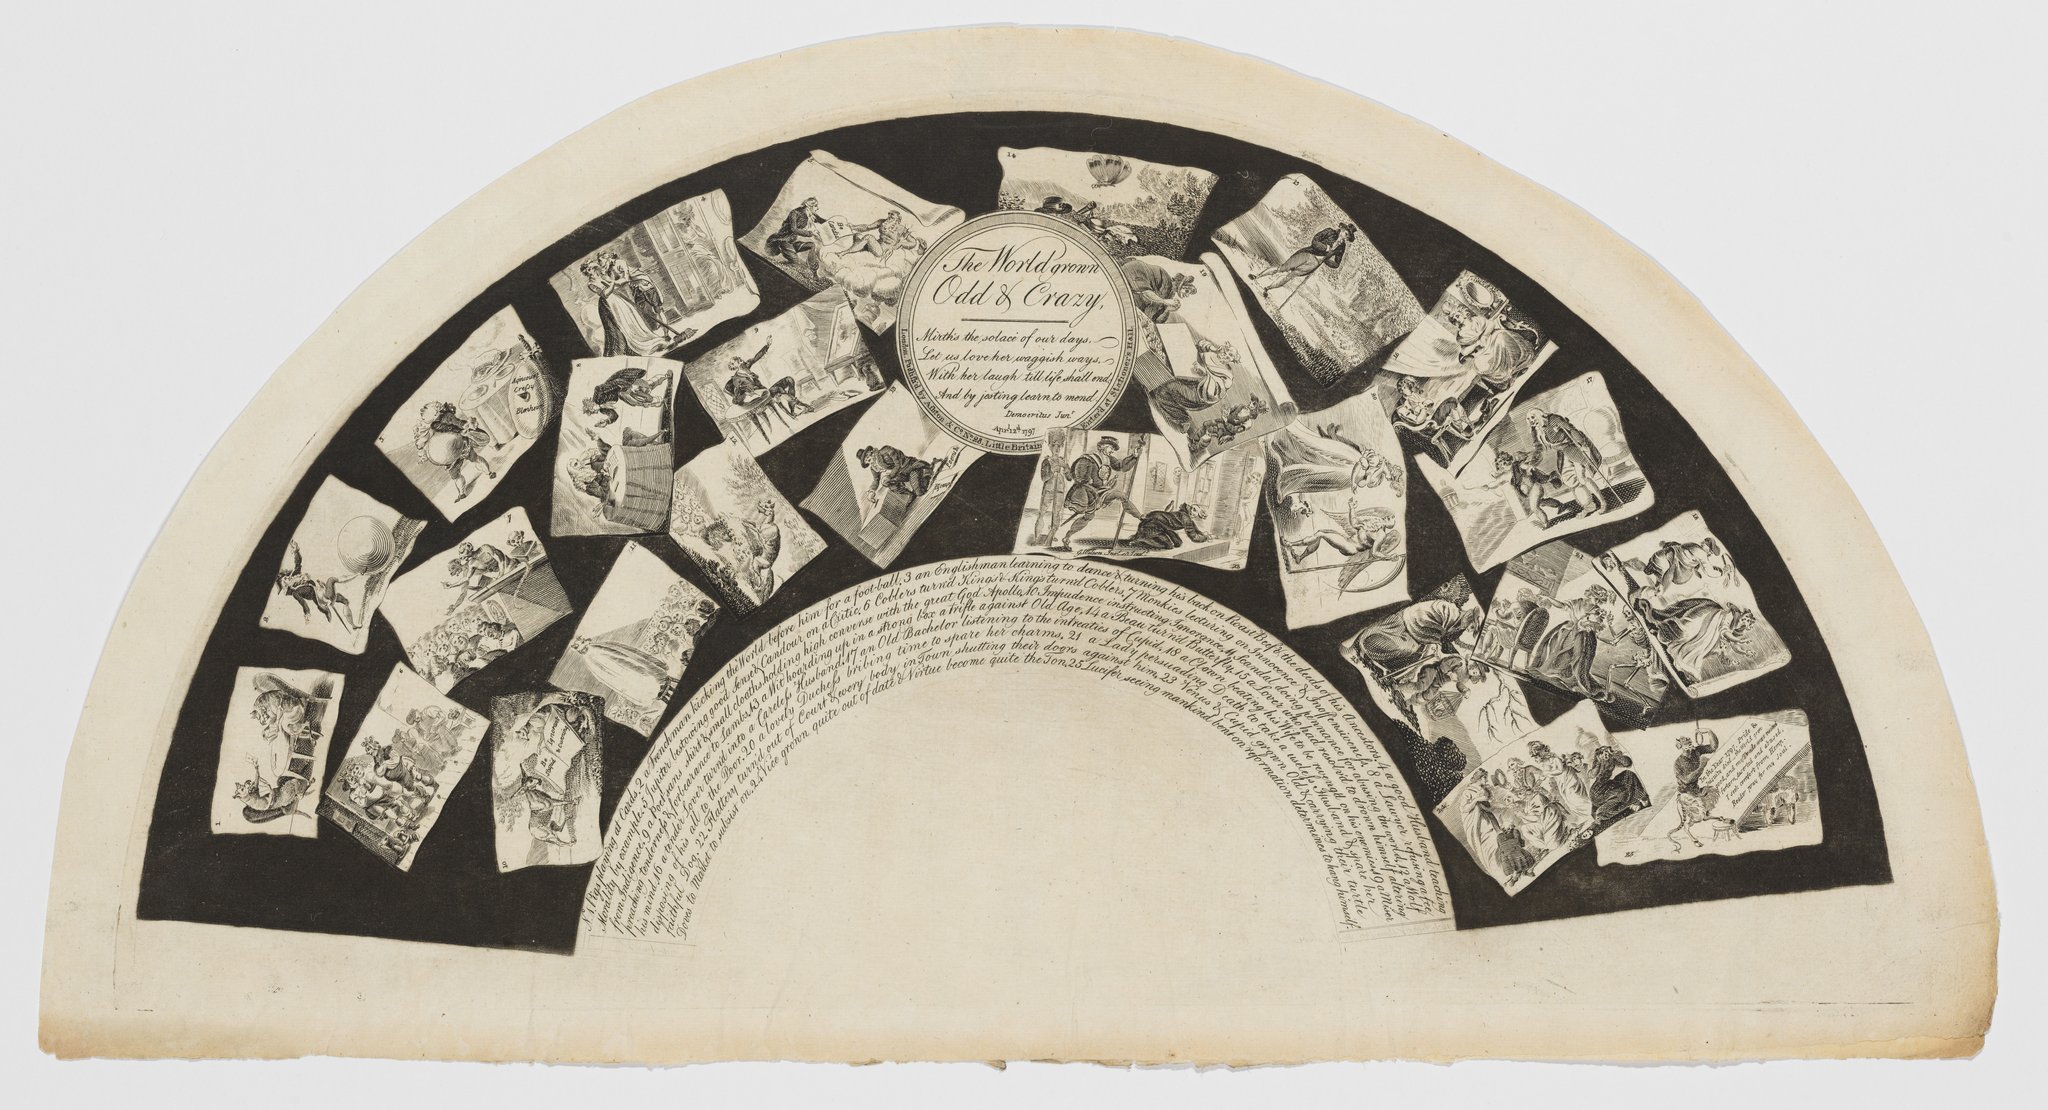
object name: print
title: The World Grown Odd and Crazy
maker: george wilson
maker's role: artist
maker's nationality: british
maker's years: 1795-1801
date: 1797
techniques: aquatint, engraving, etching